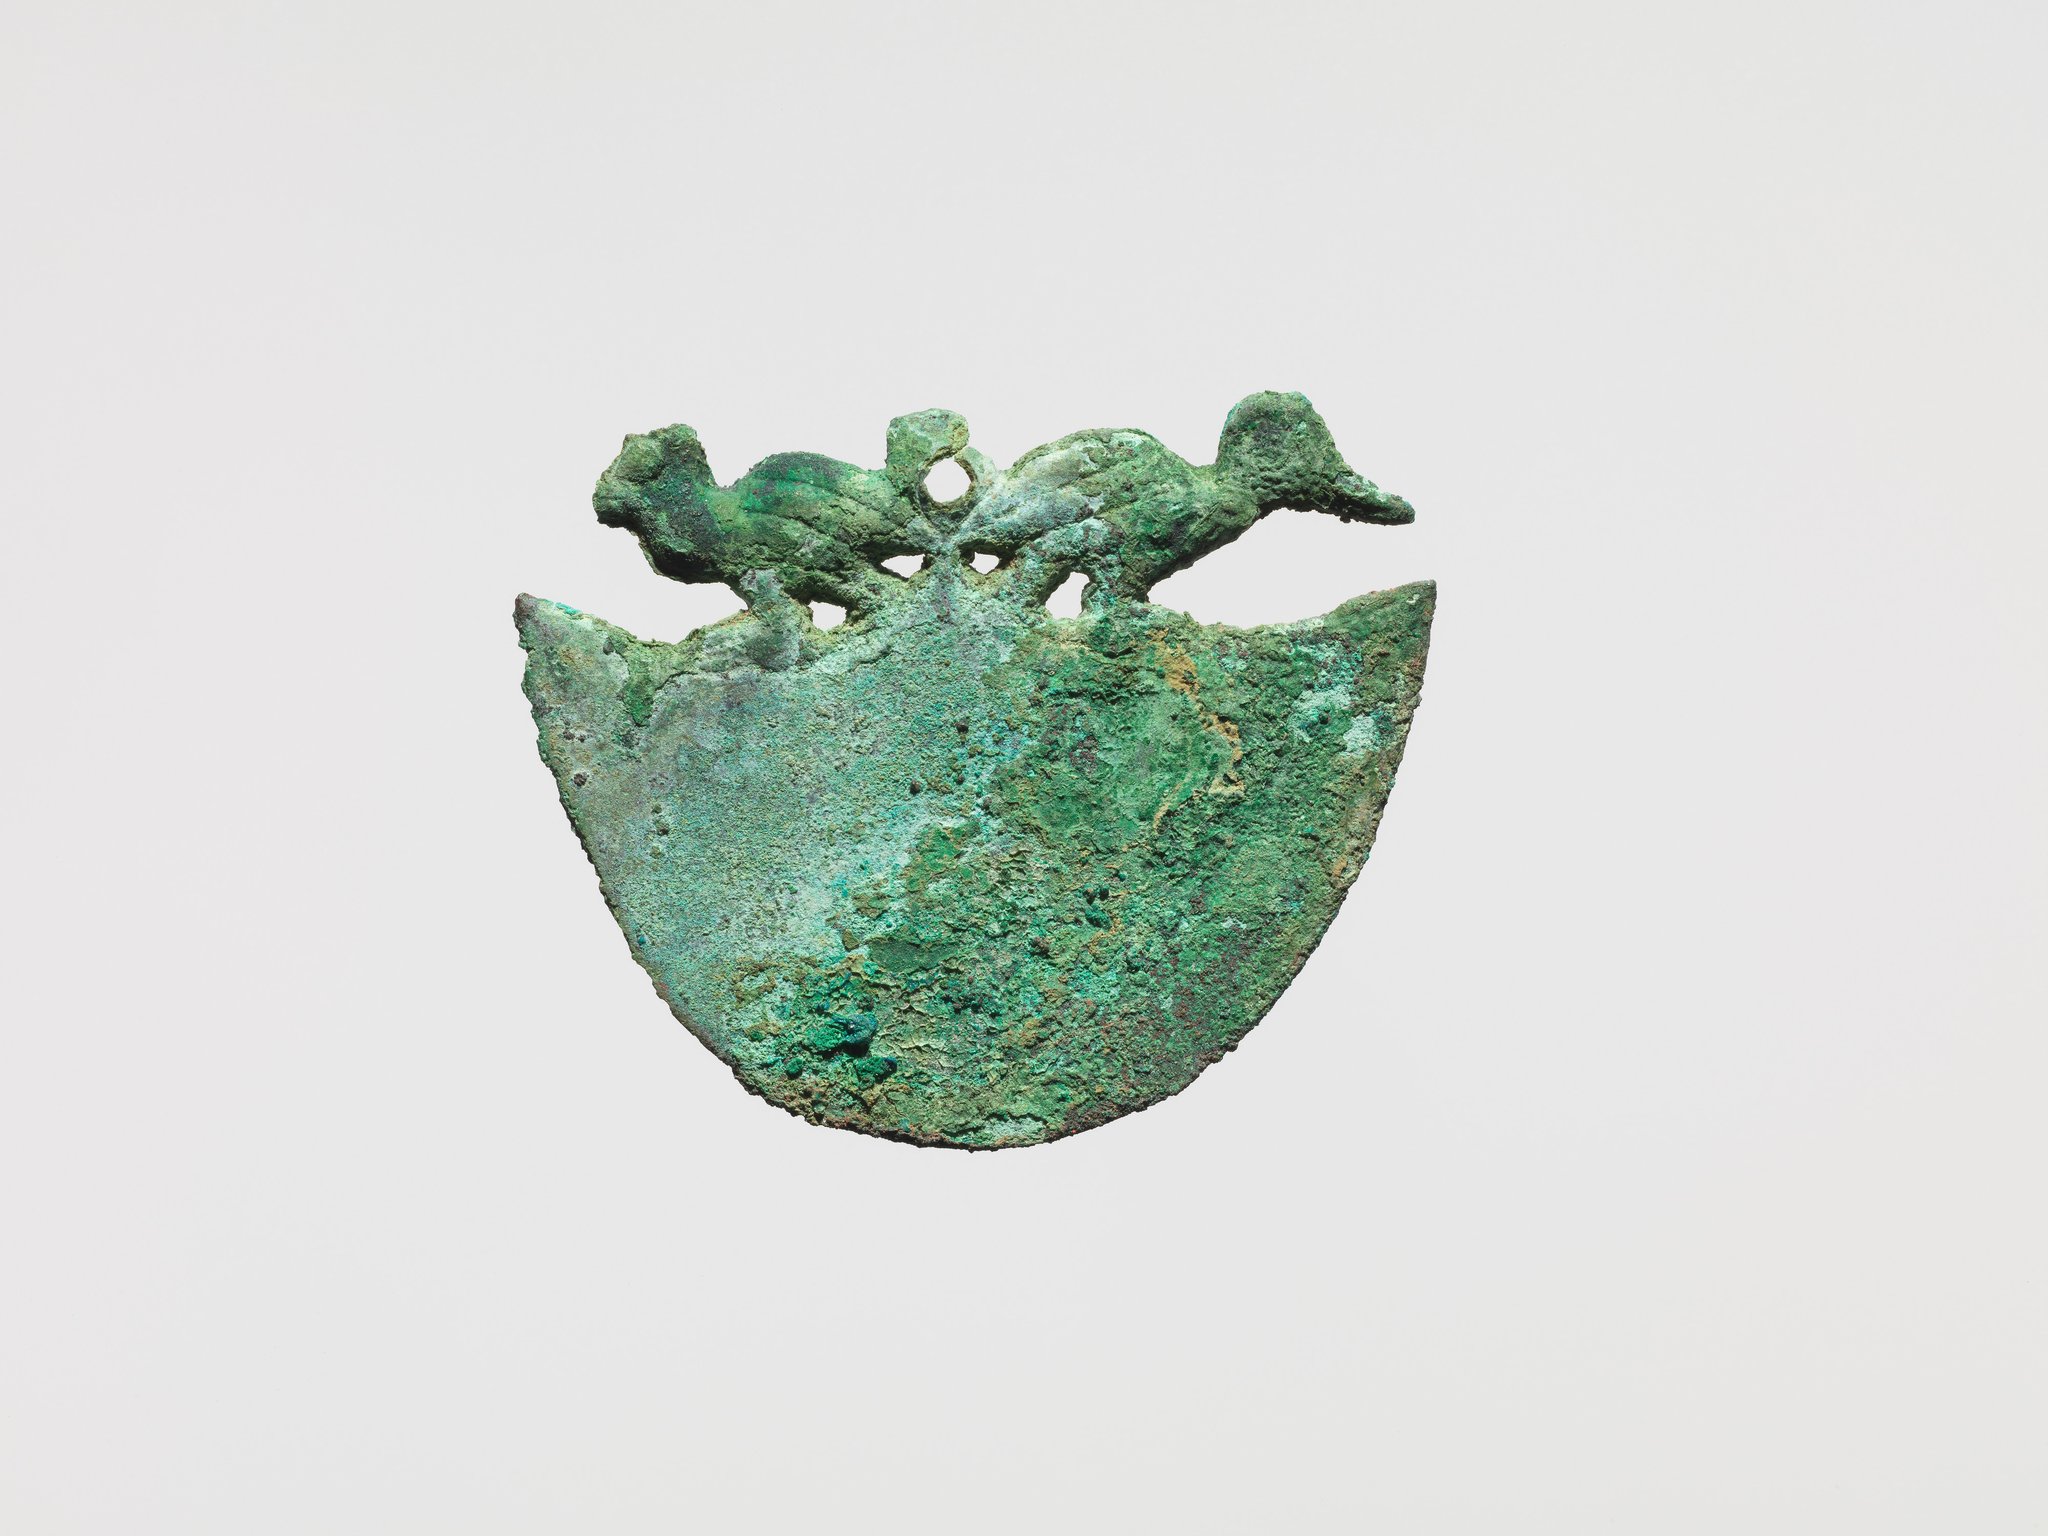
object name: ornament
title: Crescent Ornament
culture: moche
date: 501-700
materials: copper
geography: peru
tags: birds